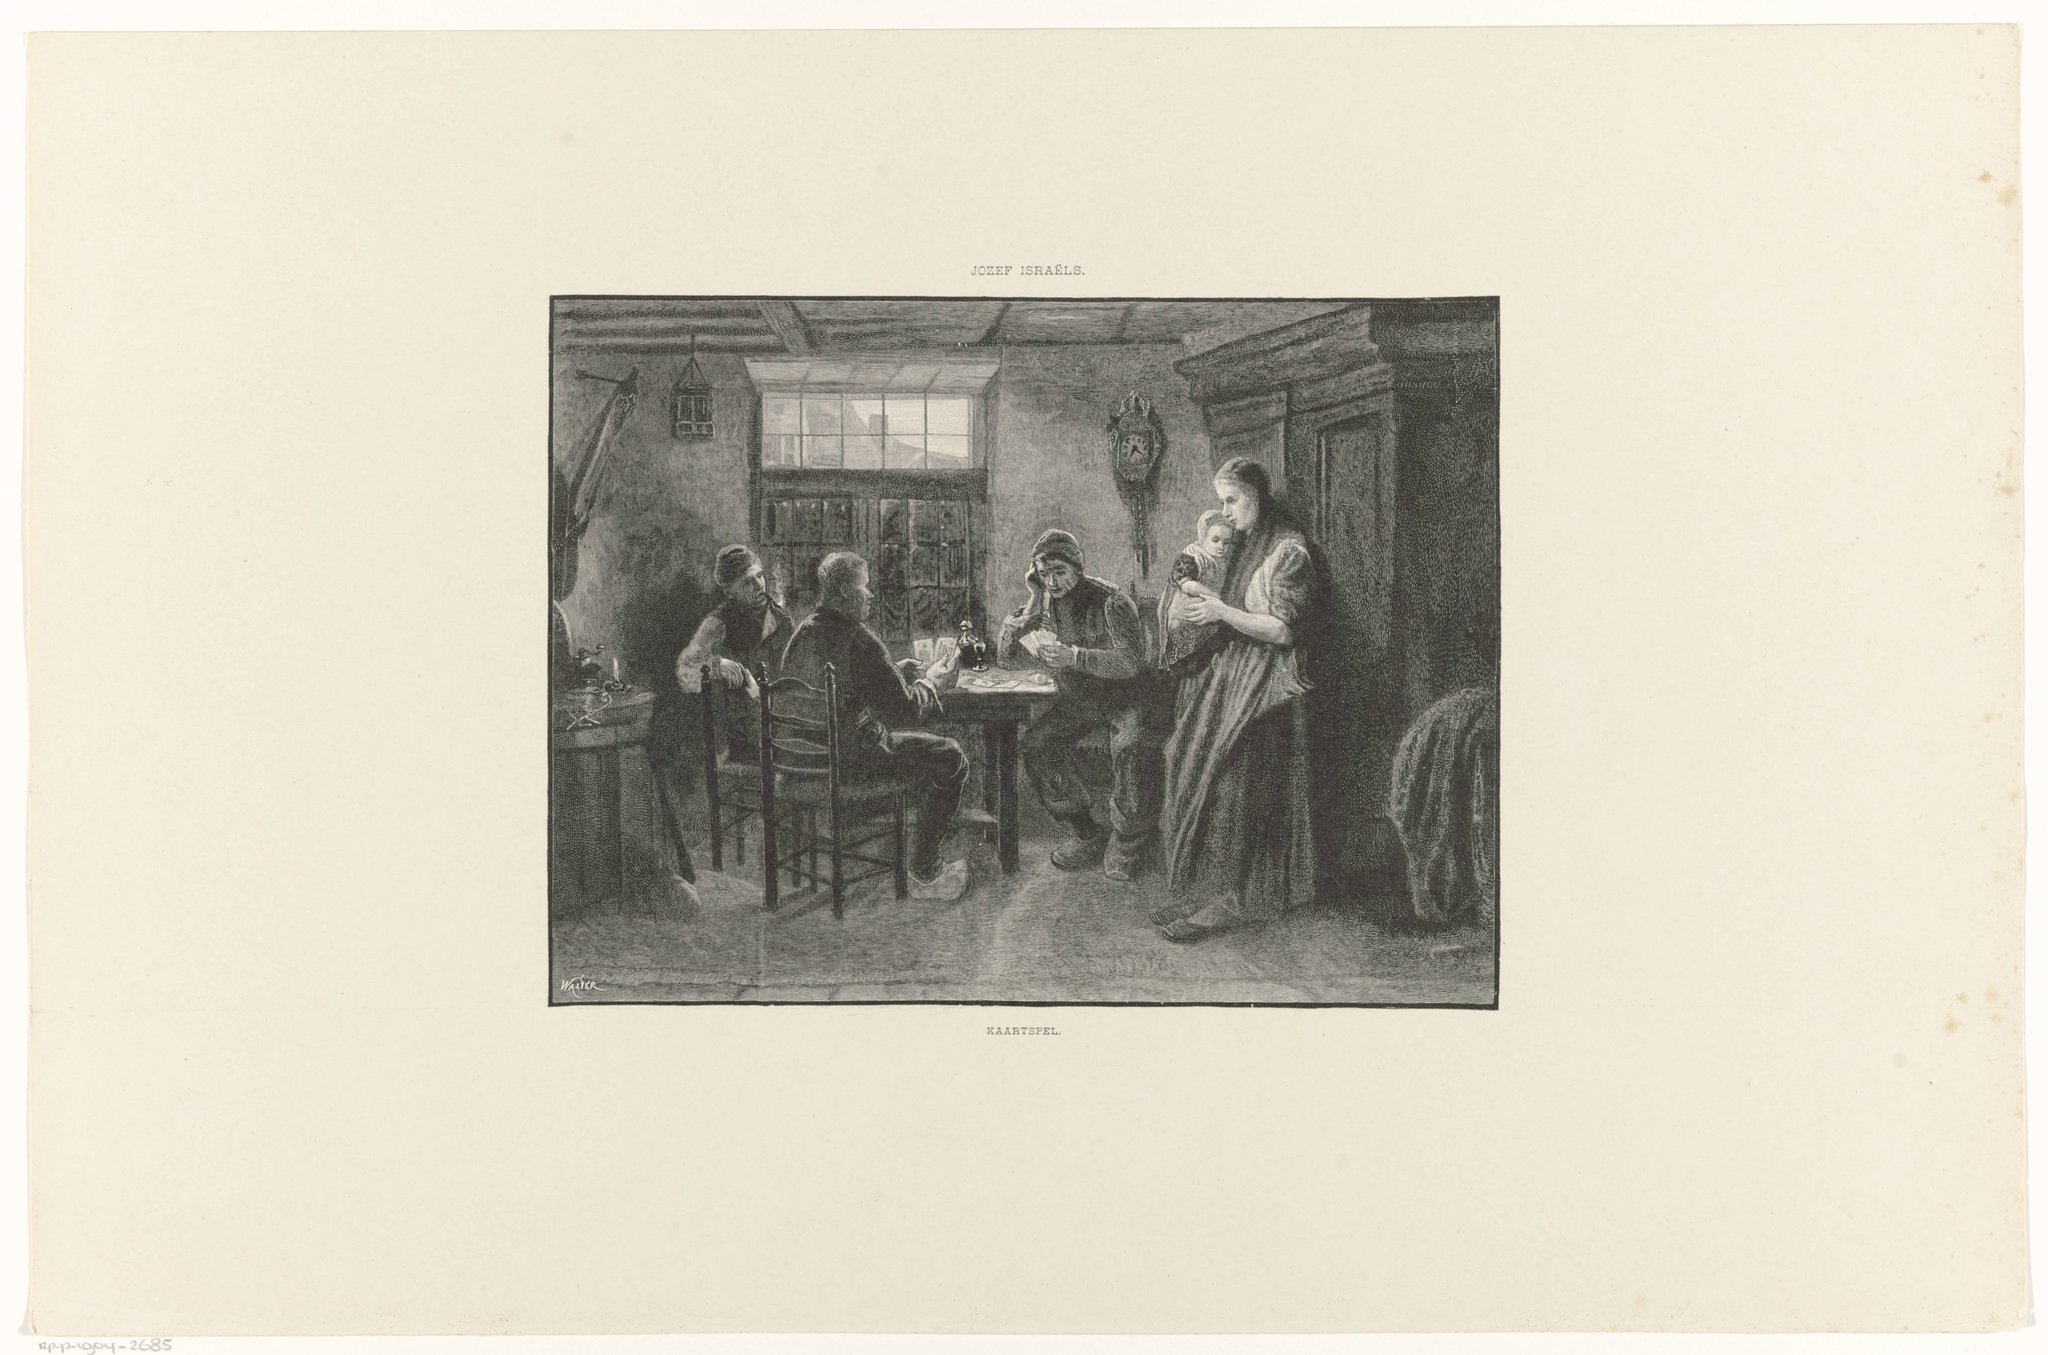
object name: print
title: Kaartspel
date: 1849-1895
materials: paper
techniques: engraving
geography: netherlands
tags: card games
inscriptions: collector's mark: Lugt 2228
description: Interieur met drie mannen die aan een tafel een kaartspel spelen. Rechts staat een vrouw met een klein kind op haar arm.